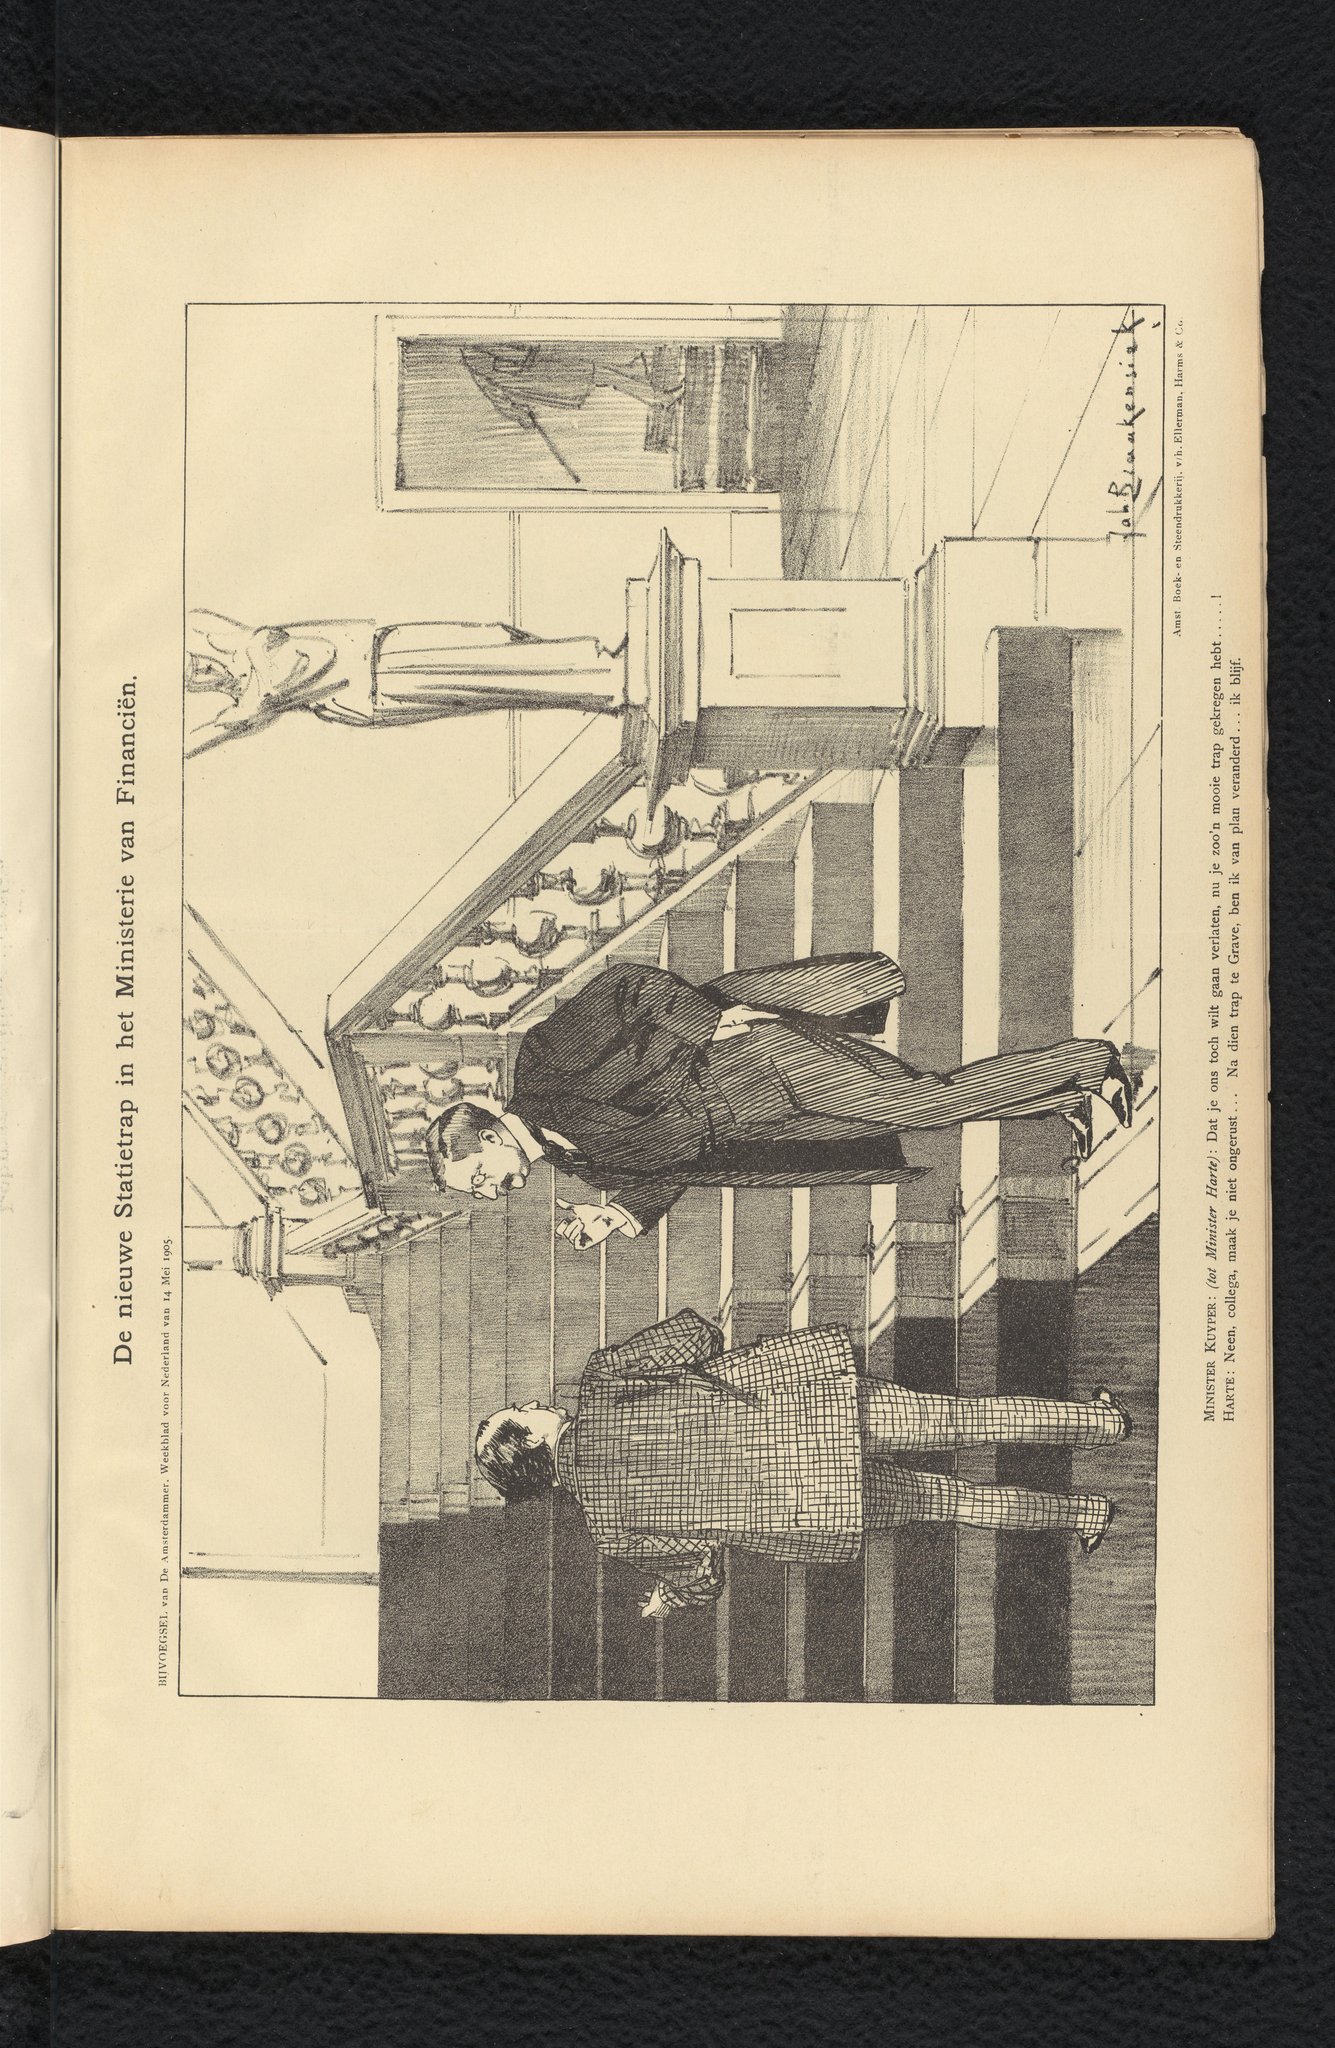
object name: cartoon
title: De nieuwe Statietrap in het Ministerie van Financiën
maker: johan braakensiek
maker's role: draughtsman, print maker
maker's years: 1858-1940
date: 1905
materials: paper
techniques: lithograph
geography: netherlands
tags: the hague, abraham kuyper, minister ~ government, staircase, political caricatures and satires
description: Minister van Financiën Harte van Tecklenburg zegt premier Kuyper toe toch te zullen blijven nu zijn ministerie een nieuwe trap heeft gekregen.